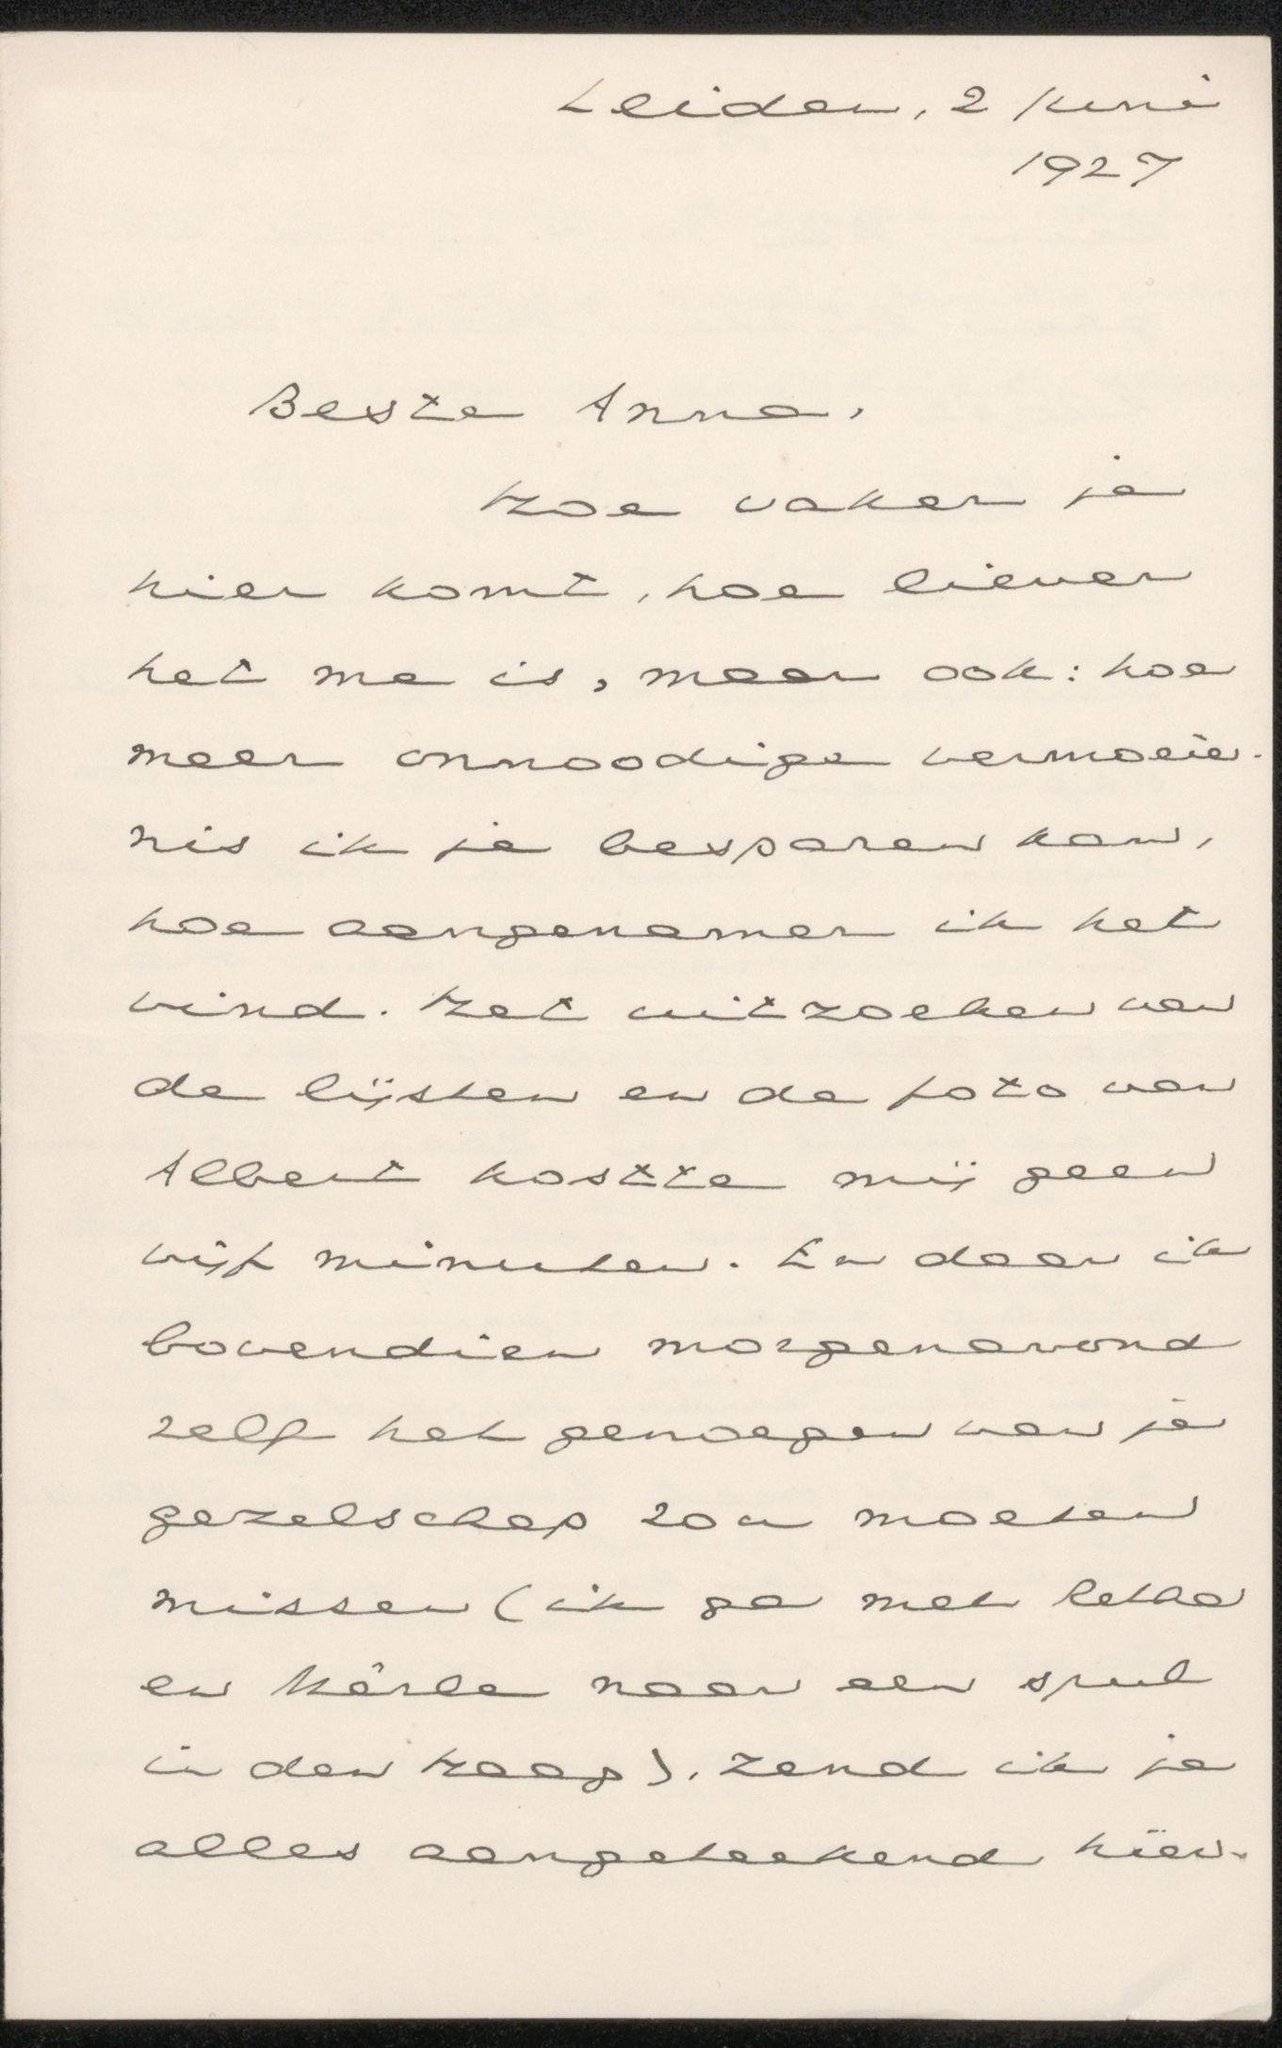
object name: letter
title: Brief aan Anna Dorothea Dirks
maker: johan huizinga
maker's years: 1872-1945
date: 1927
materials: ink, paper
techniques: pen, writing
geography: leiden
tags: paris, paul verlaine, artist, anna dorothea dirks, haarlem, publisher, hermanus diedericus tjeenk willink (1843-1917), photography, cinematography, family life, illustration ~ printed matter, book, historical persons (portraits and scenes from the life)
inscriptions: collector's mark: ‘RPK’, watermark